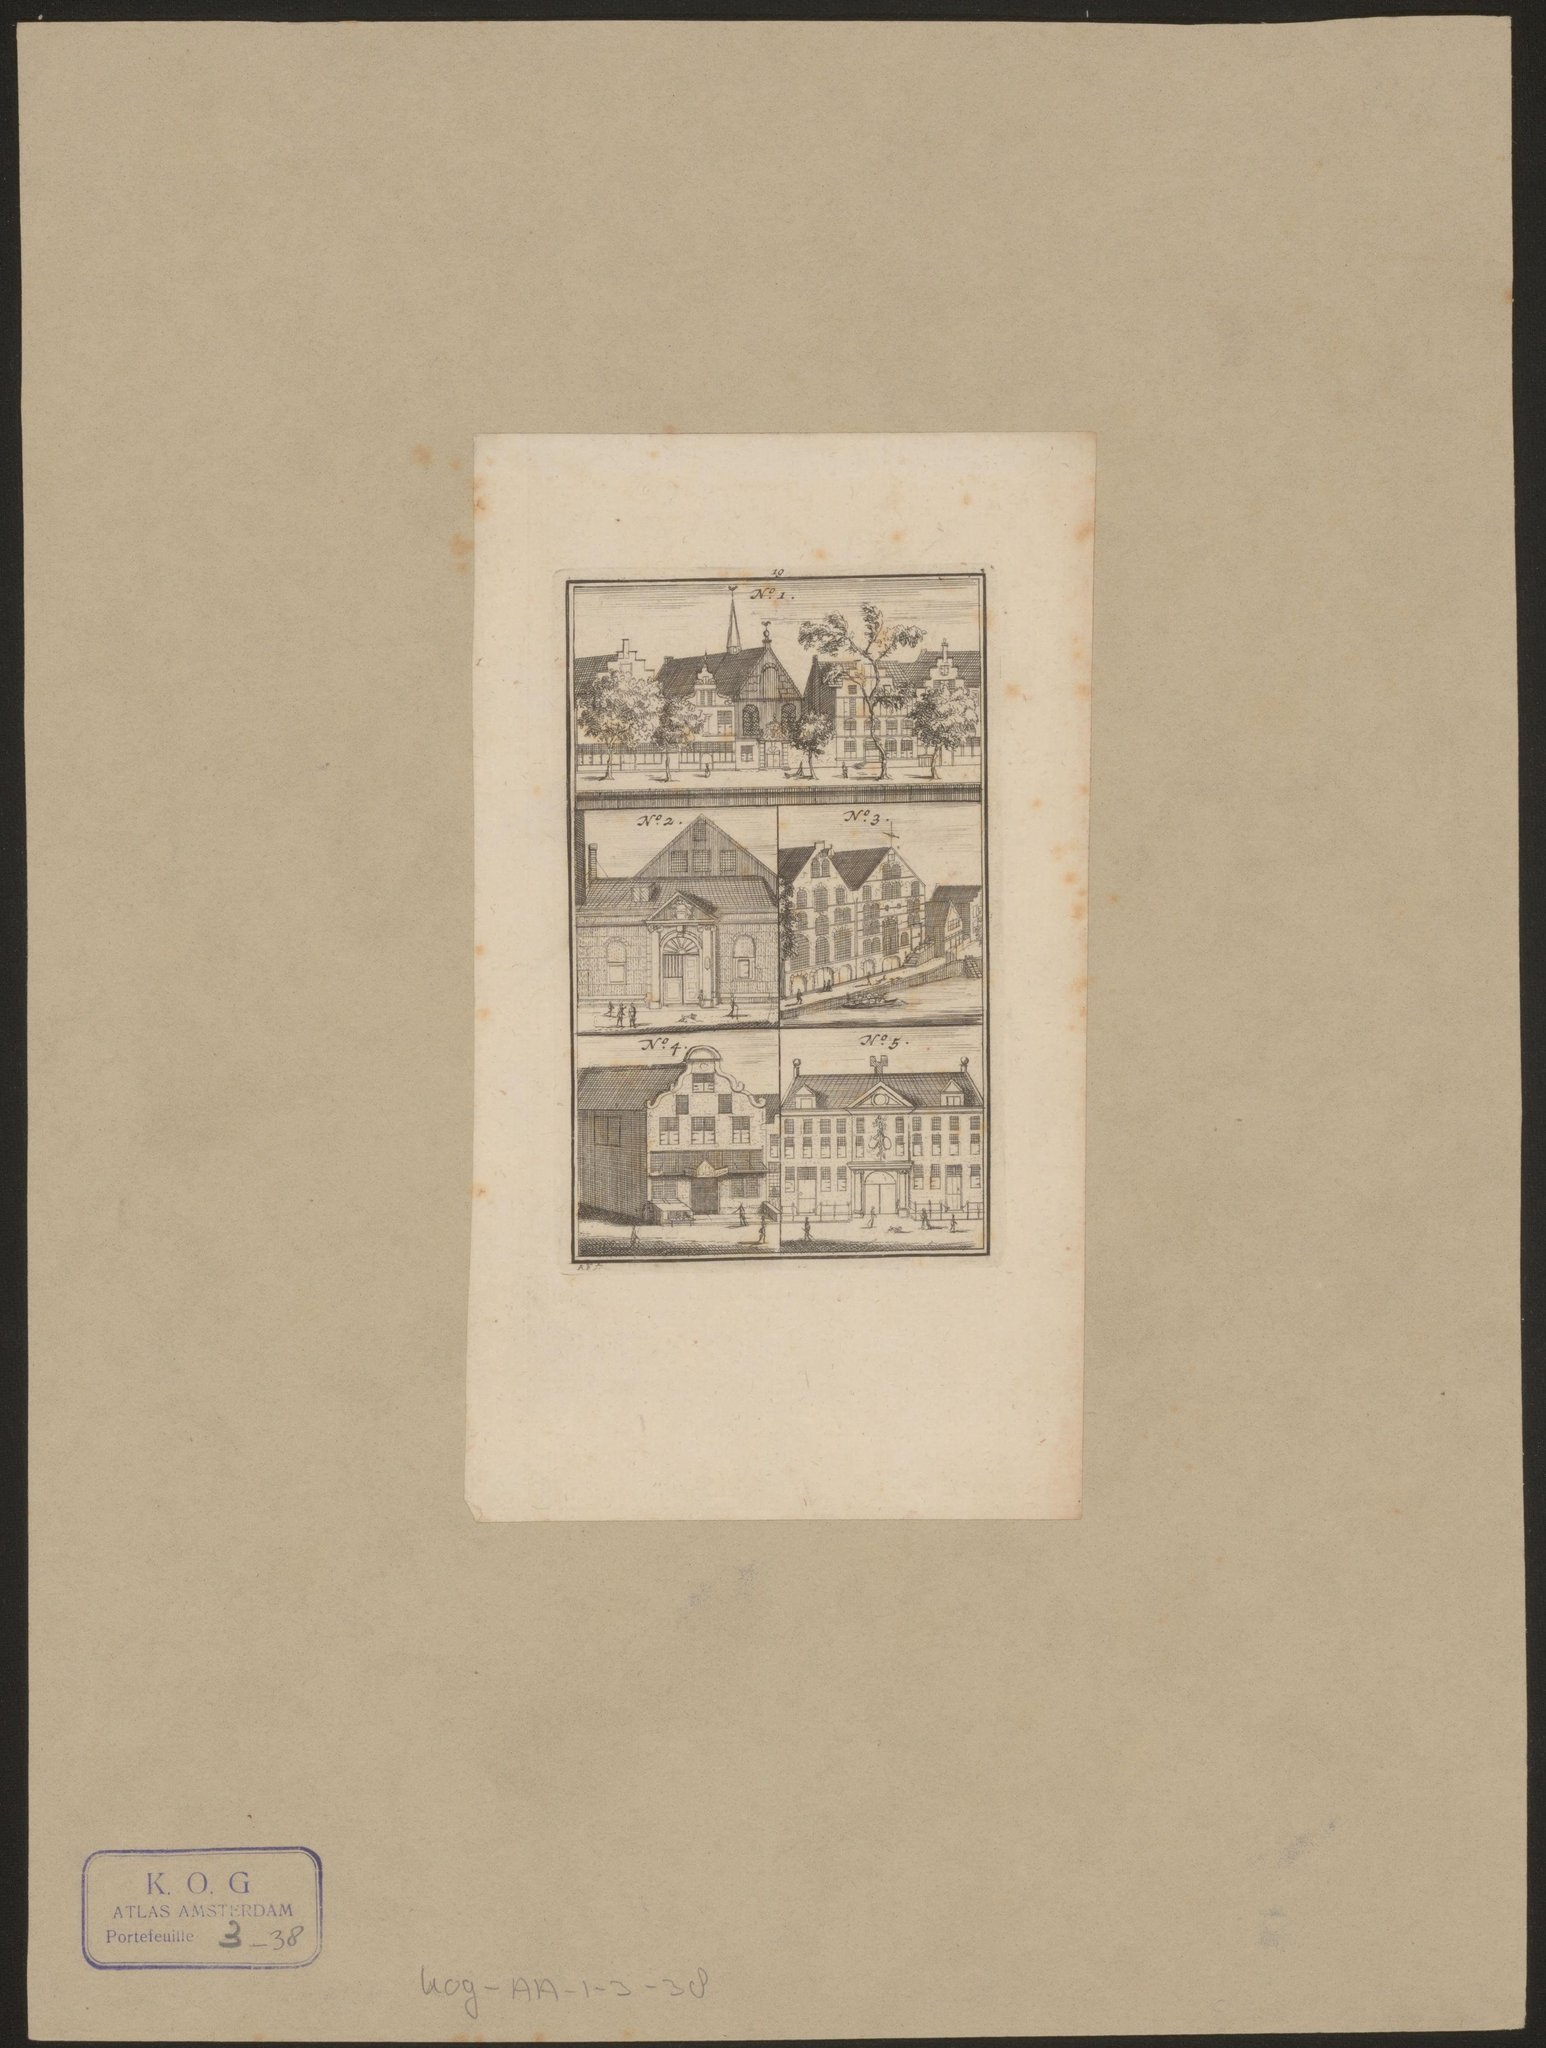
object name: page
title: Vijf gezichten op Amsterdam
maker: Anonymous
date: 1600-1699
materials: paper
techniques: etching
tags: city-view in general; 'veduta', amsterdam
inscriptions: signature: ‘A.F. f:.’, collector's mark: ‘3-38’ Lugt 1641b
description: Onderwerpsrubriek binnen de Atlas Amsterdam: Panorama's en verzamelprenten. Genummerd: 19.